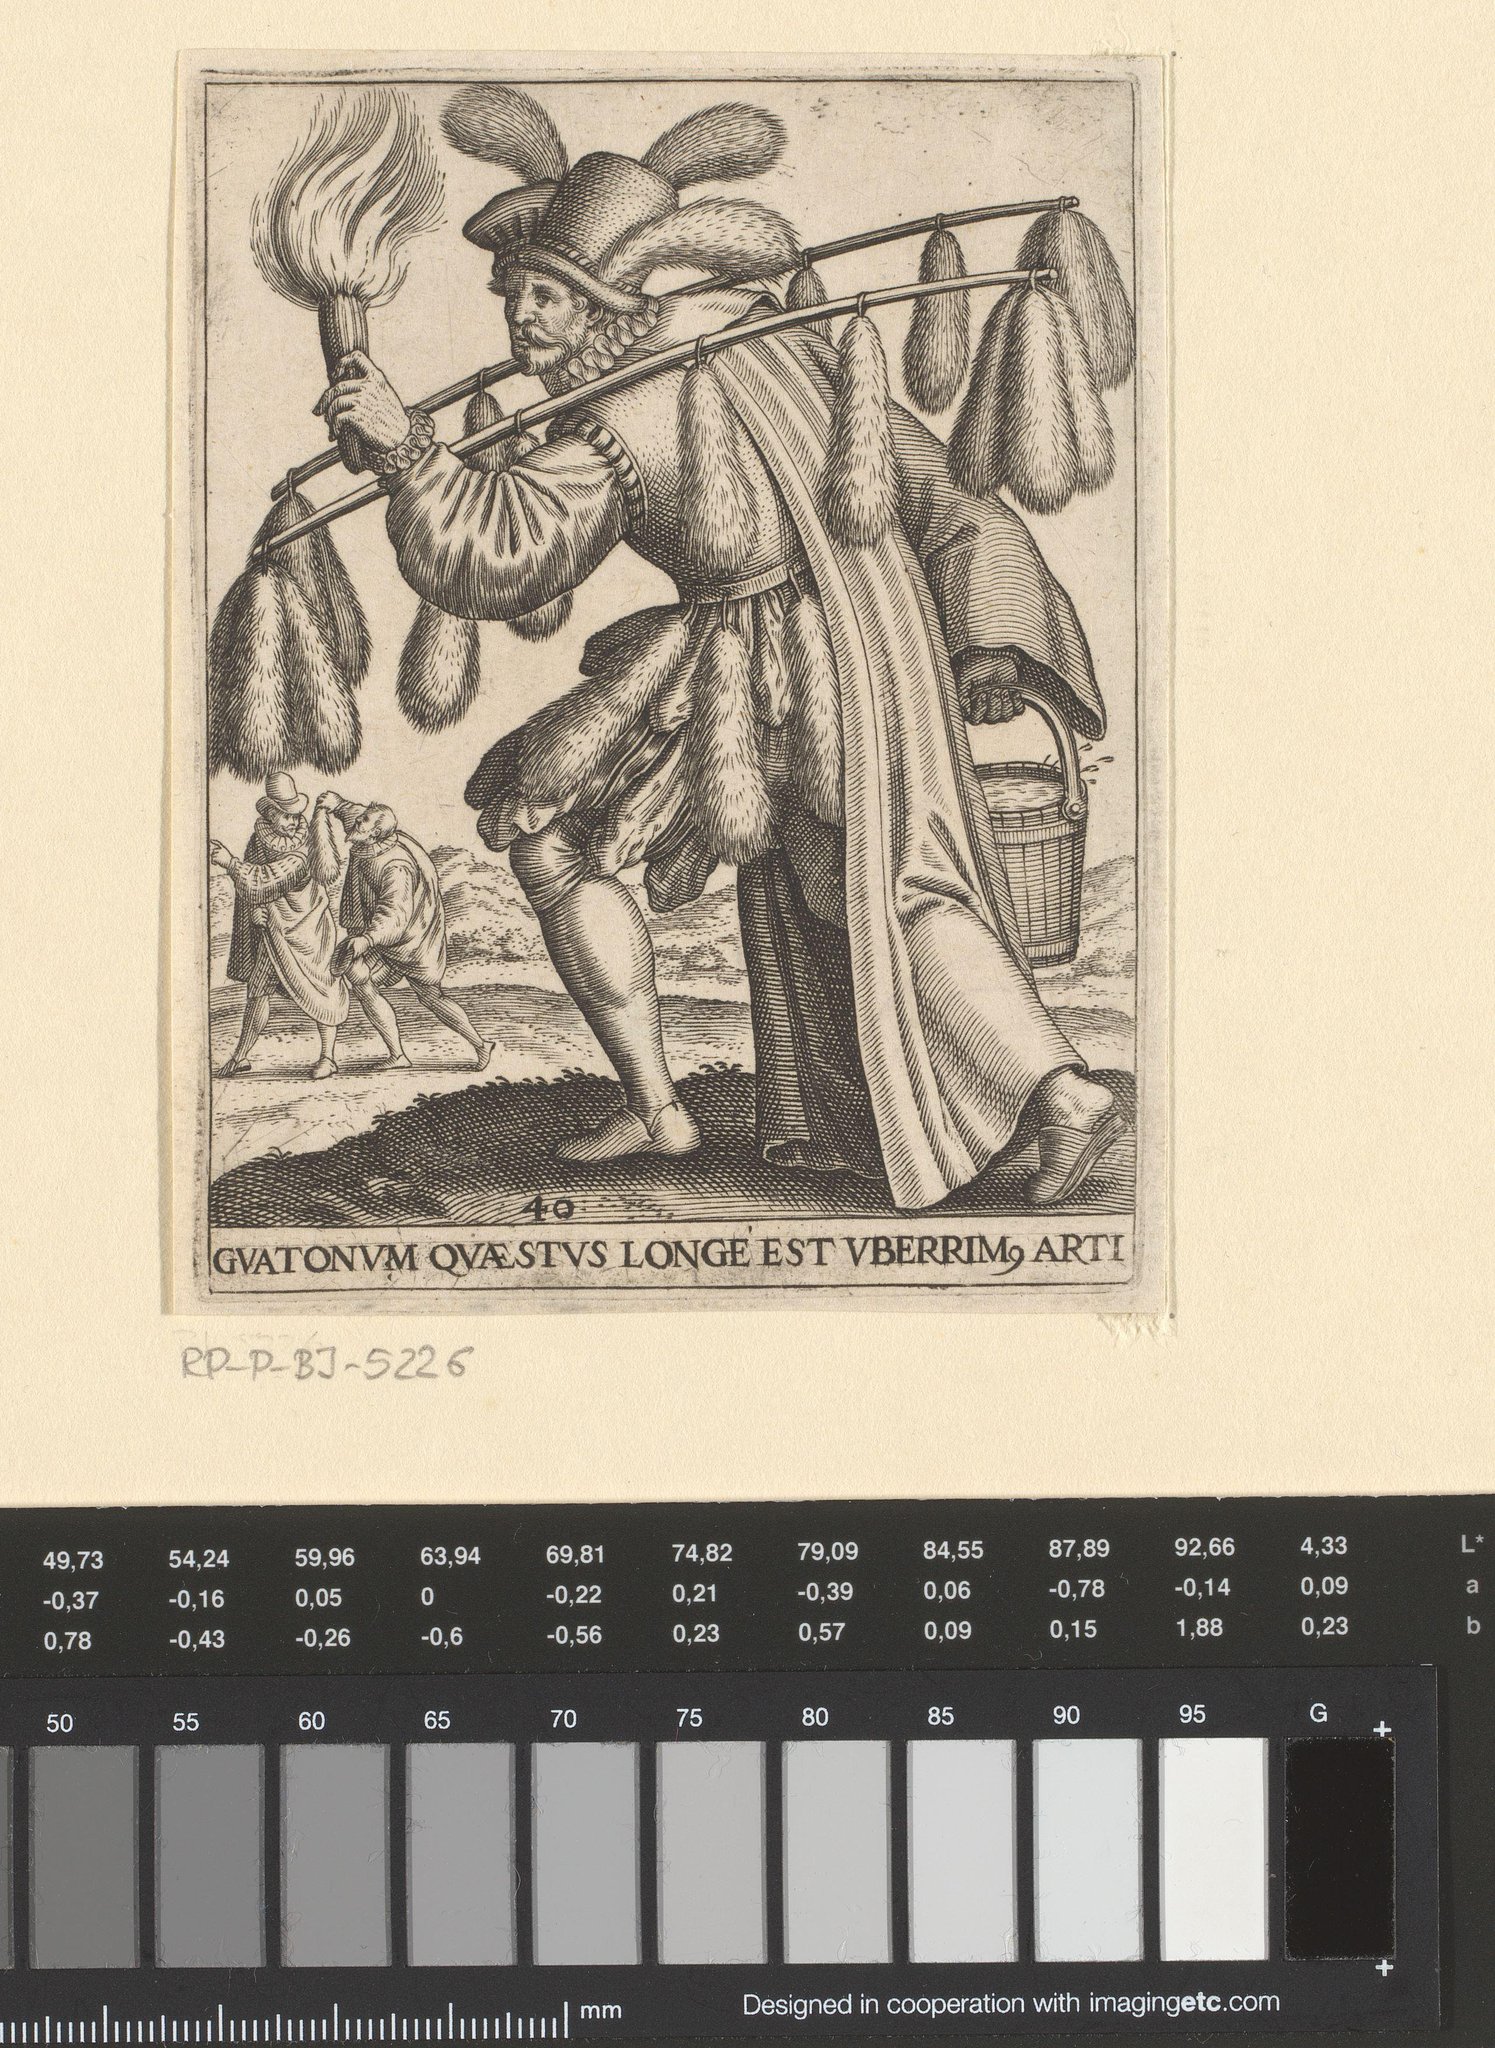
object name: print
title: GUATONUM QUAESTUS LONGE EST UBERRIM, ARTI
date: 1596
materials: paper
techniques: engraving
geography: frankfurt am main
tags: fraudulence, swindling, existence and modes of existence (+ emblematical representation of concept), dishonesty, falsety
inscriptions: collector's mark: Lugt 240, inscription: ‘GUATONUM QUAESTUS LONGE EST UBERRIM, ARTI’, number: ‘40’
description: Een lopende man draagt een brandende toorts en een emmer water. Zijn kleding is aan zijn ene zijde anders dan aan zijn andere kant (mi-partie); hij draagt stokken waaraan vossenstaarten hangen over zijn schouder. Aangezien "Fuchsschwanz" in het Duits, naast vossenstaart tevens flikflooierij betekent, en ook de bijbehorende tekst (in het boek) van vleierij spreekt, moet de man met de vossenstaarten waarschijnlijk als een flikflooier worden beschouwd. Op de achtergrond een man die een heer een vossenstaart voorhoudt.